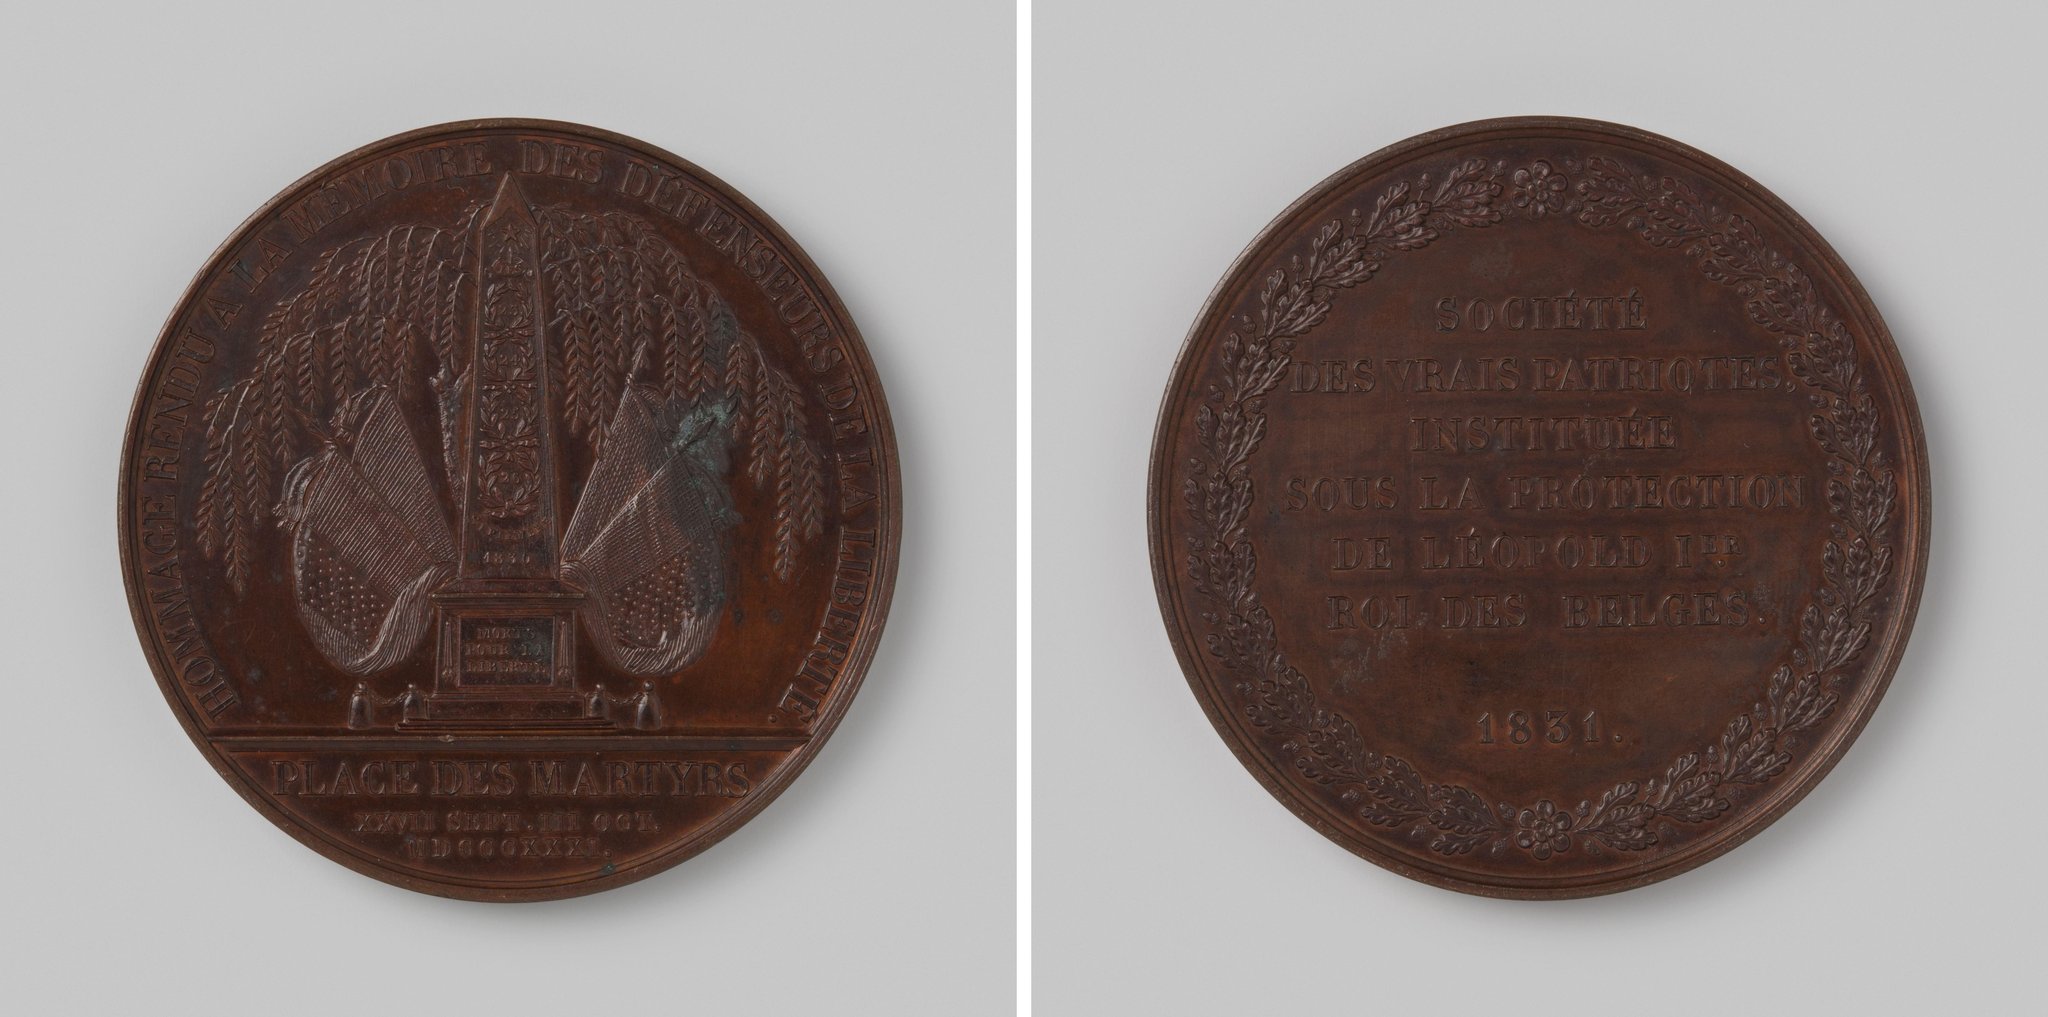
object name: history medal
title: Eerste verjaardag van de Belgische revolutie op de Place des Martyres, gevierd door de "association des vraies patriotes"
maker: m. borrel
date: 1831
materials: bronze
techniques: striking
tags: laeken, leopold i (koning der belgen)